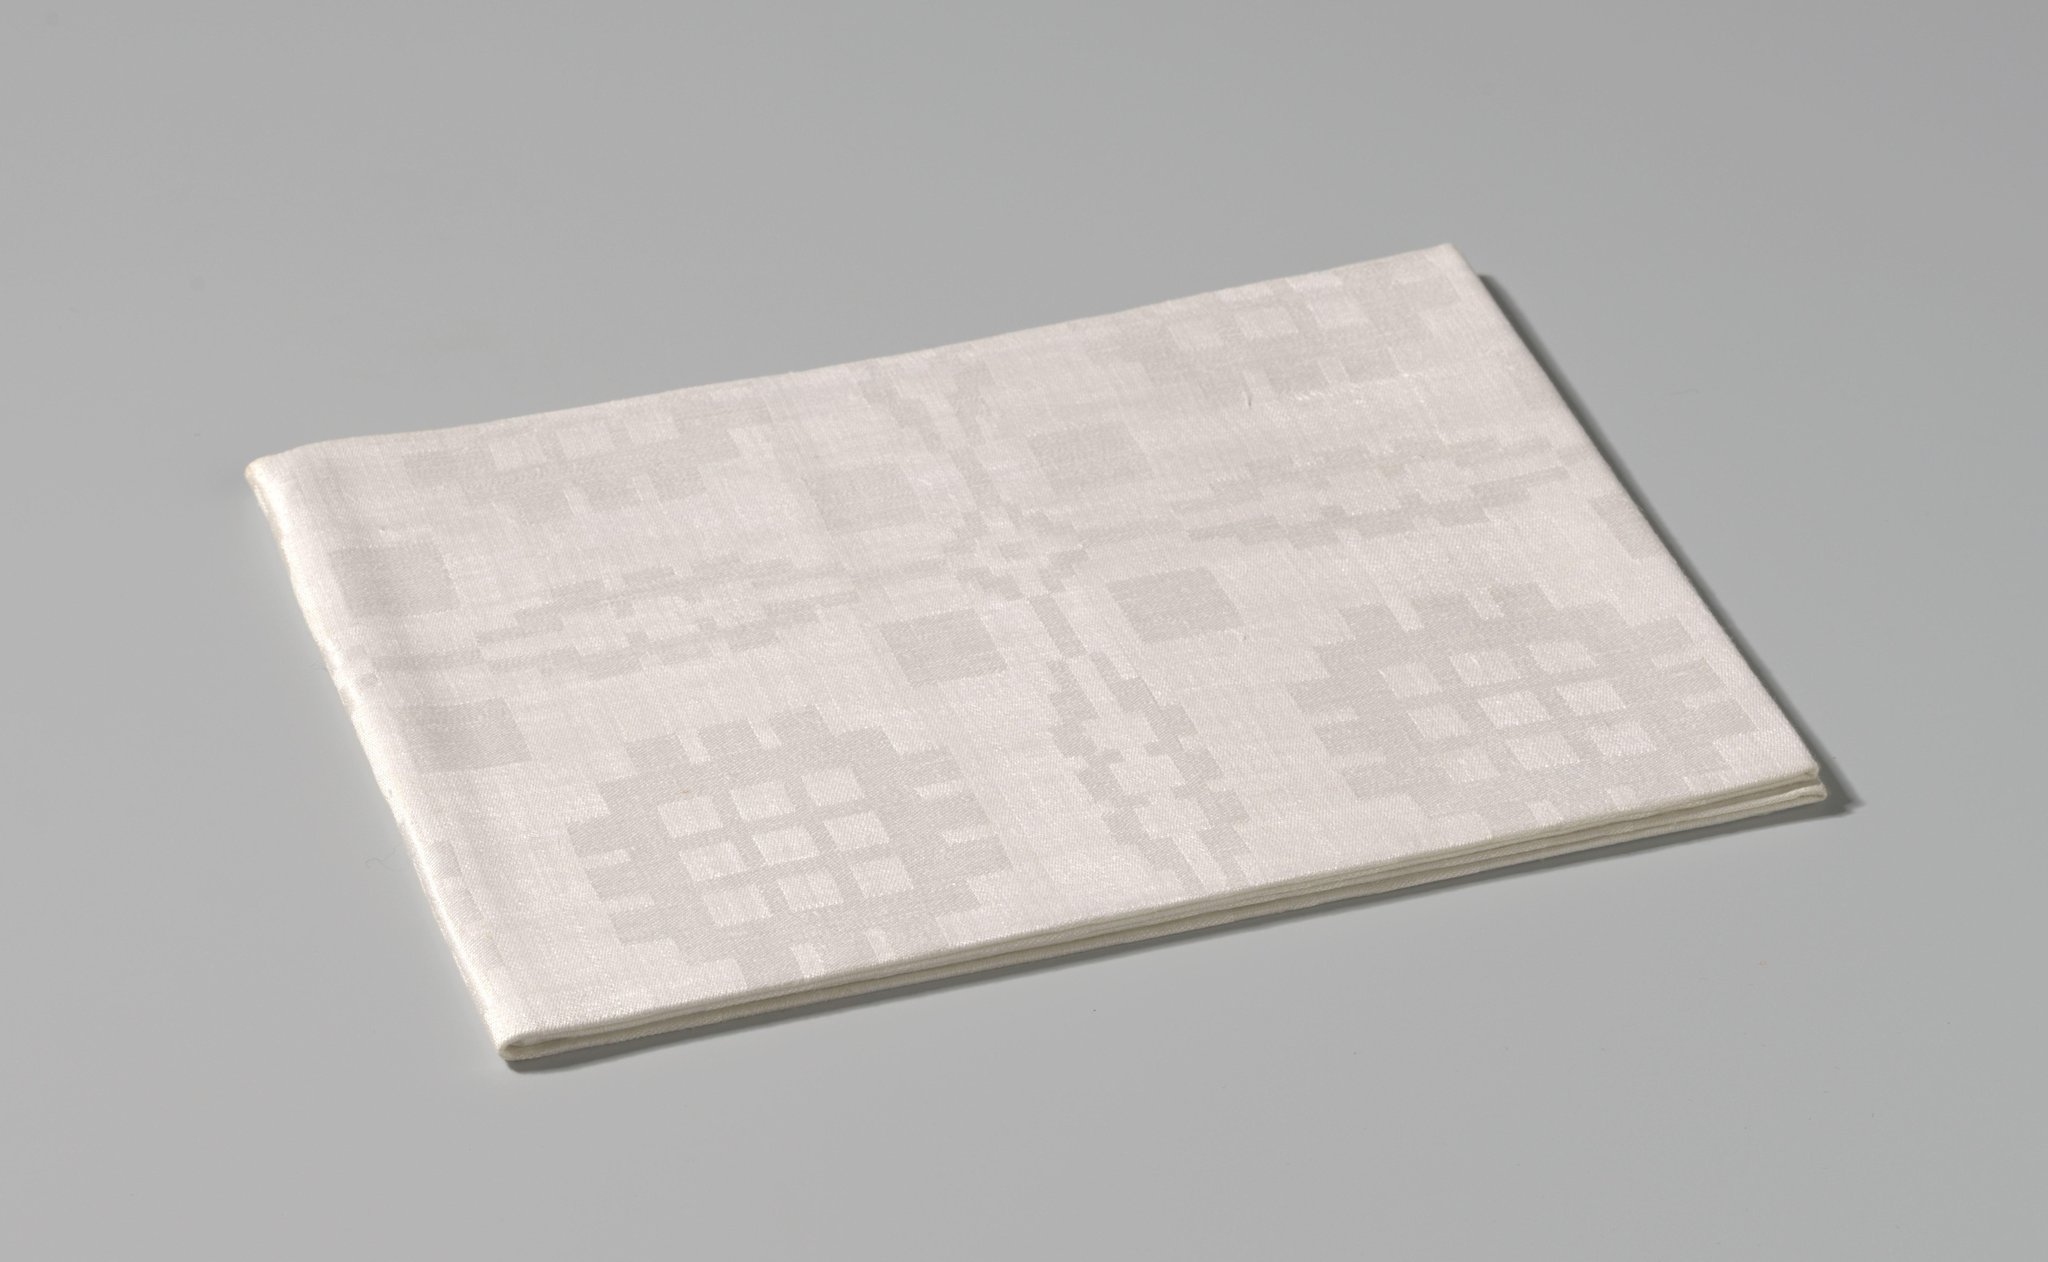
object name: napkin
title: Servet van linnen met pellenpatroon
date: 1730-1786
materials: linen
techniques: peeled fabric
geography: northern netherlands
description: wit linnen servet met pellen patroon, merk kroon IAVG 12